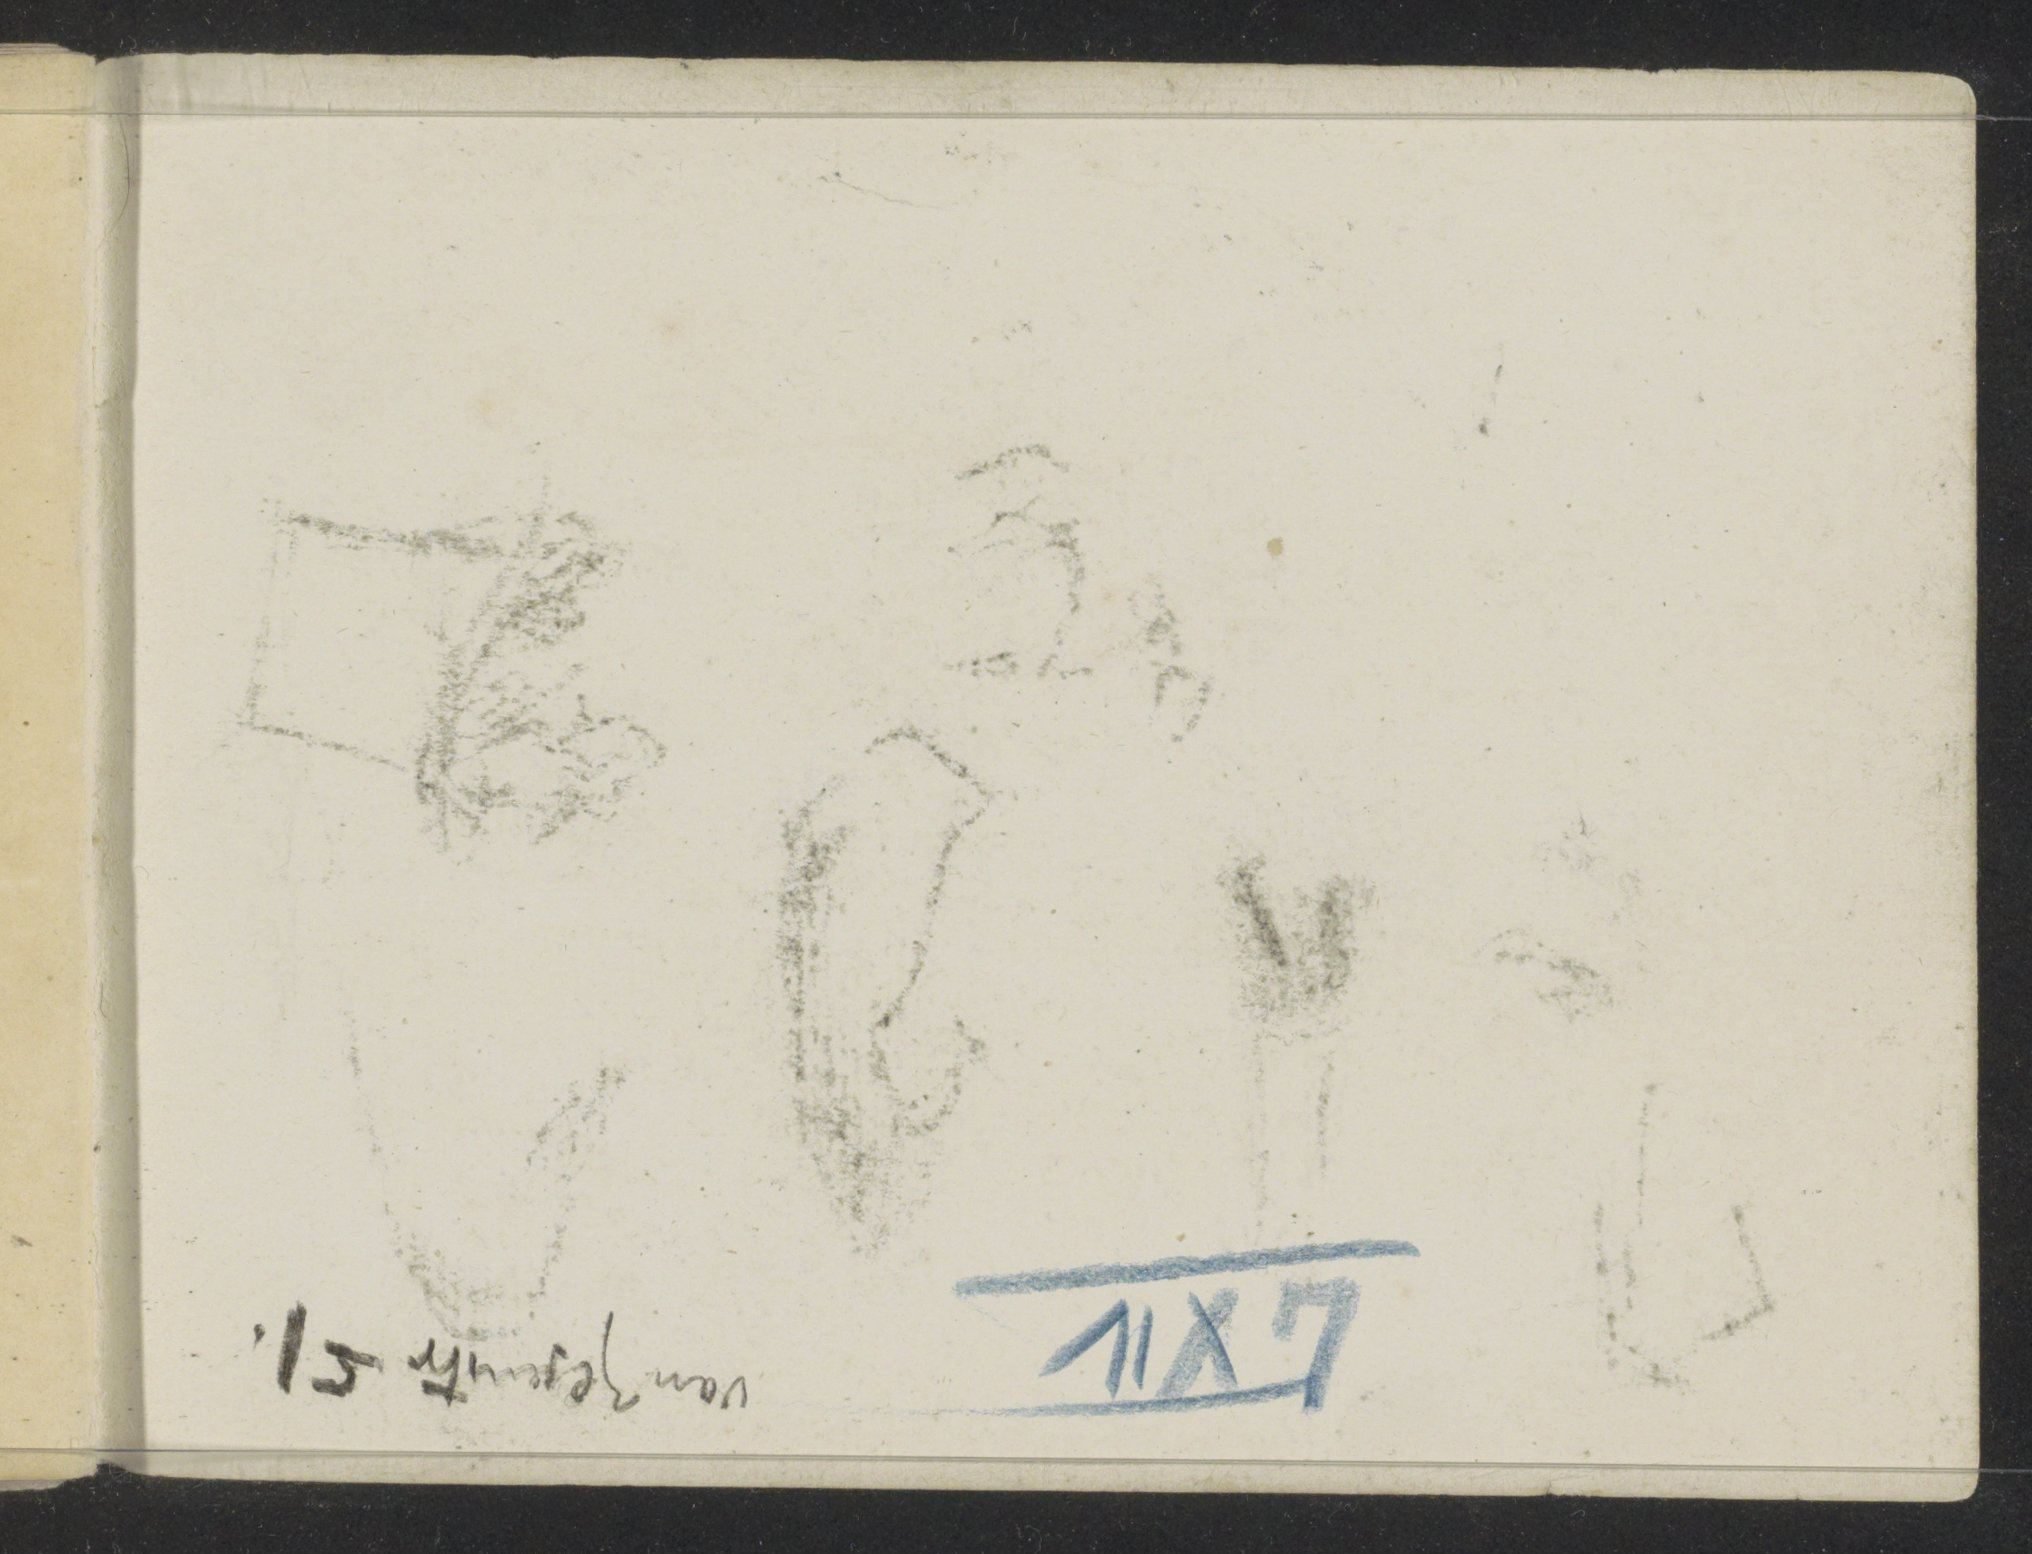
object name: endleaf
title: Annotatie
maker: isaac israels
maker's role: draughtsman, painter, print maker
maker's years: 1865-1934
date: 1886-1934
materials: chalk, paper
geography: amsterdam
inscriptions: annotation: ‘van Zegenstr[?] 51’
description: Schutblad B, achterste schutblad, uit schetsboek LXIV met 29 bladen.